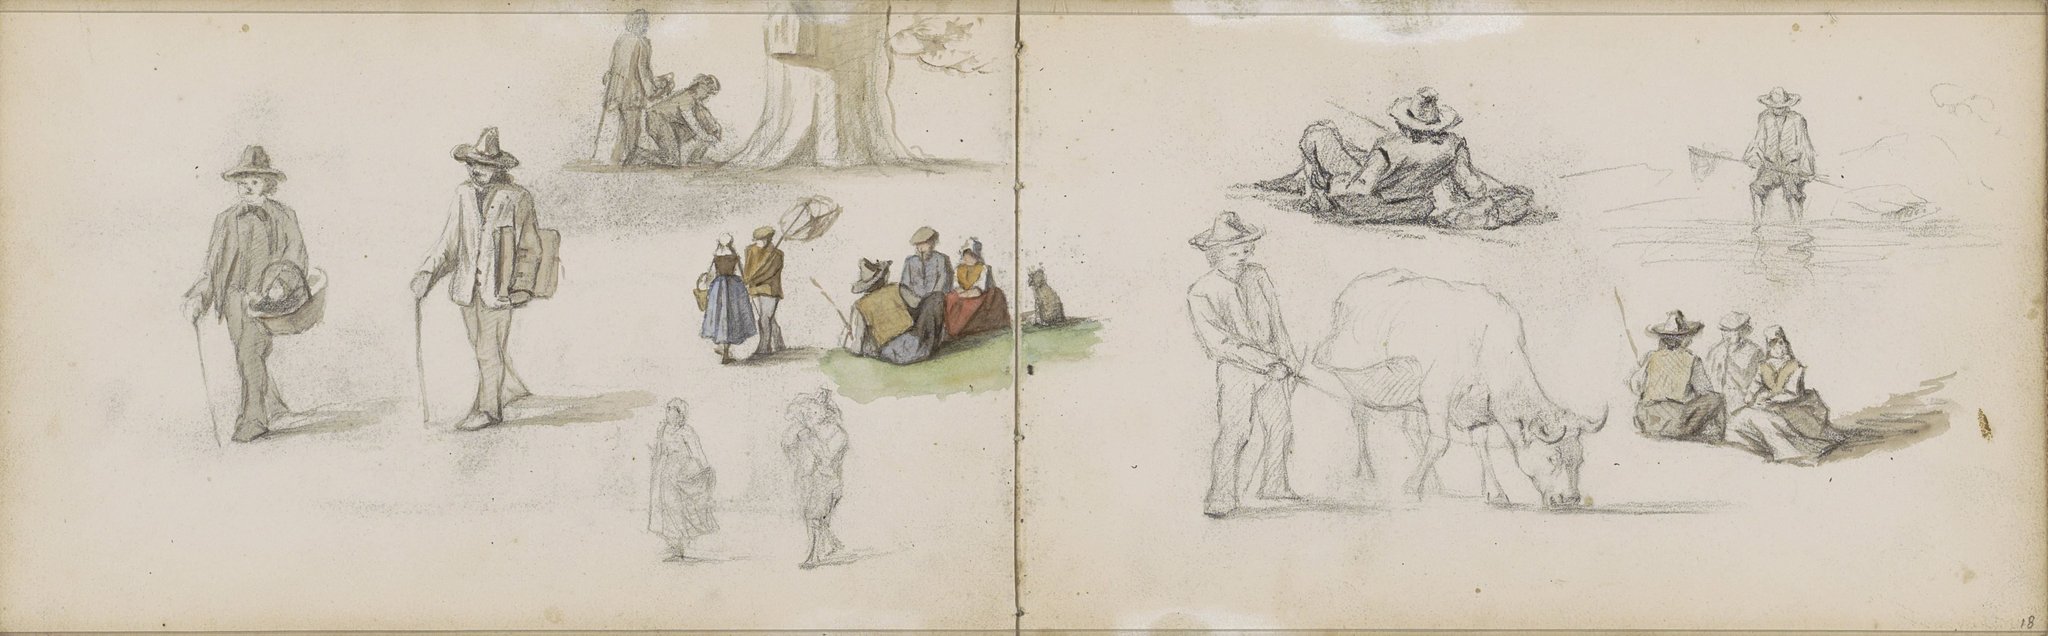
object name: sketchbook leaf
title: Figuurstudies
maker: willem cornelis rip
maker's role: draughtsman, painter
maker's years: 1856-1922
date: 1874-1875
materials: paper, pencil, watercolor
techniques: brush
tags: cow, (traveller) resting in the open air, fisherman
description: Onder andere studies van een boer met een stier, een visser, een rustende reiziger en wandelaars. Blad 17 verso en 18 recto uit een schetsboek met 46 bladen.